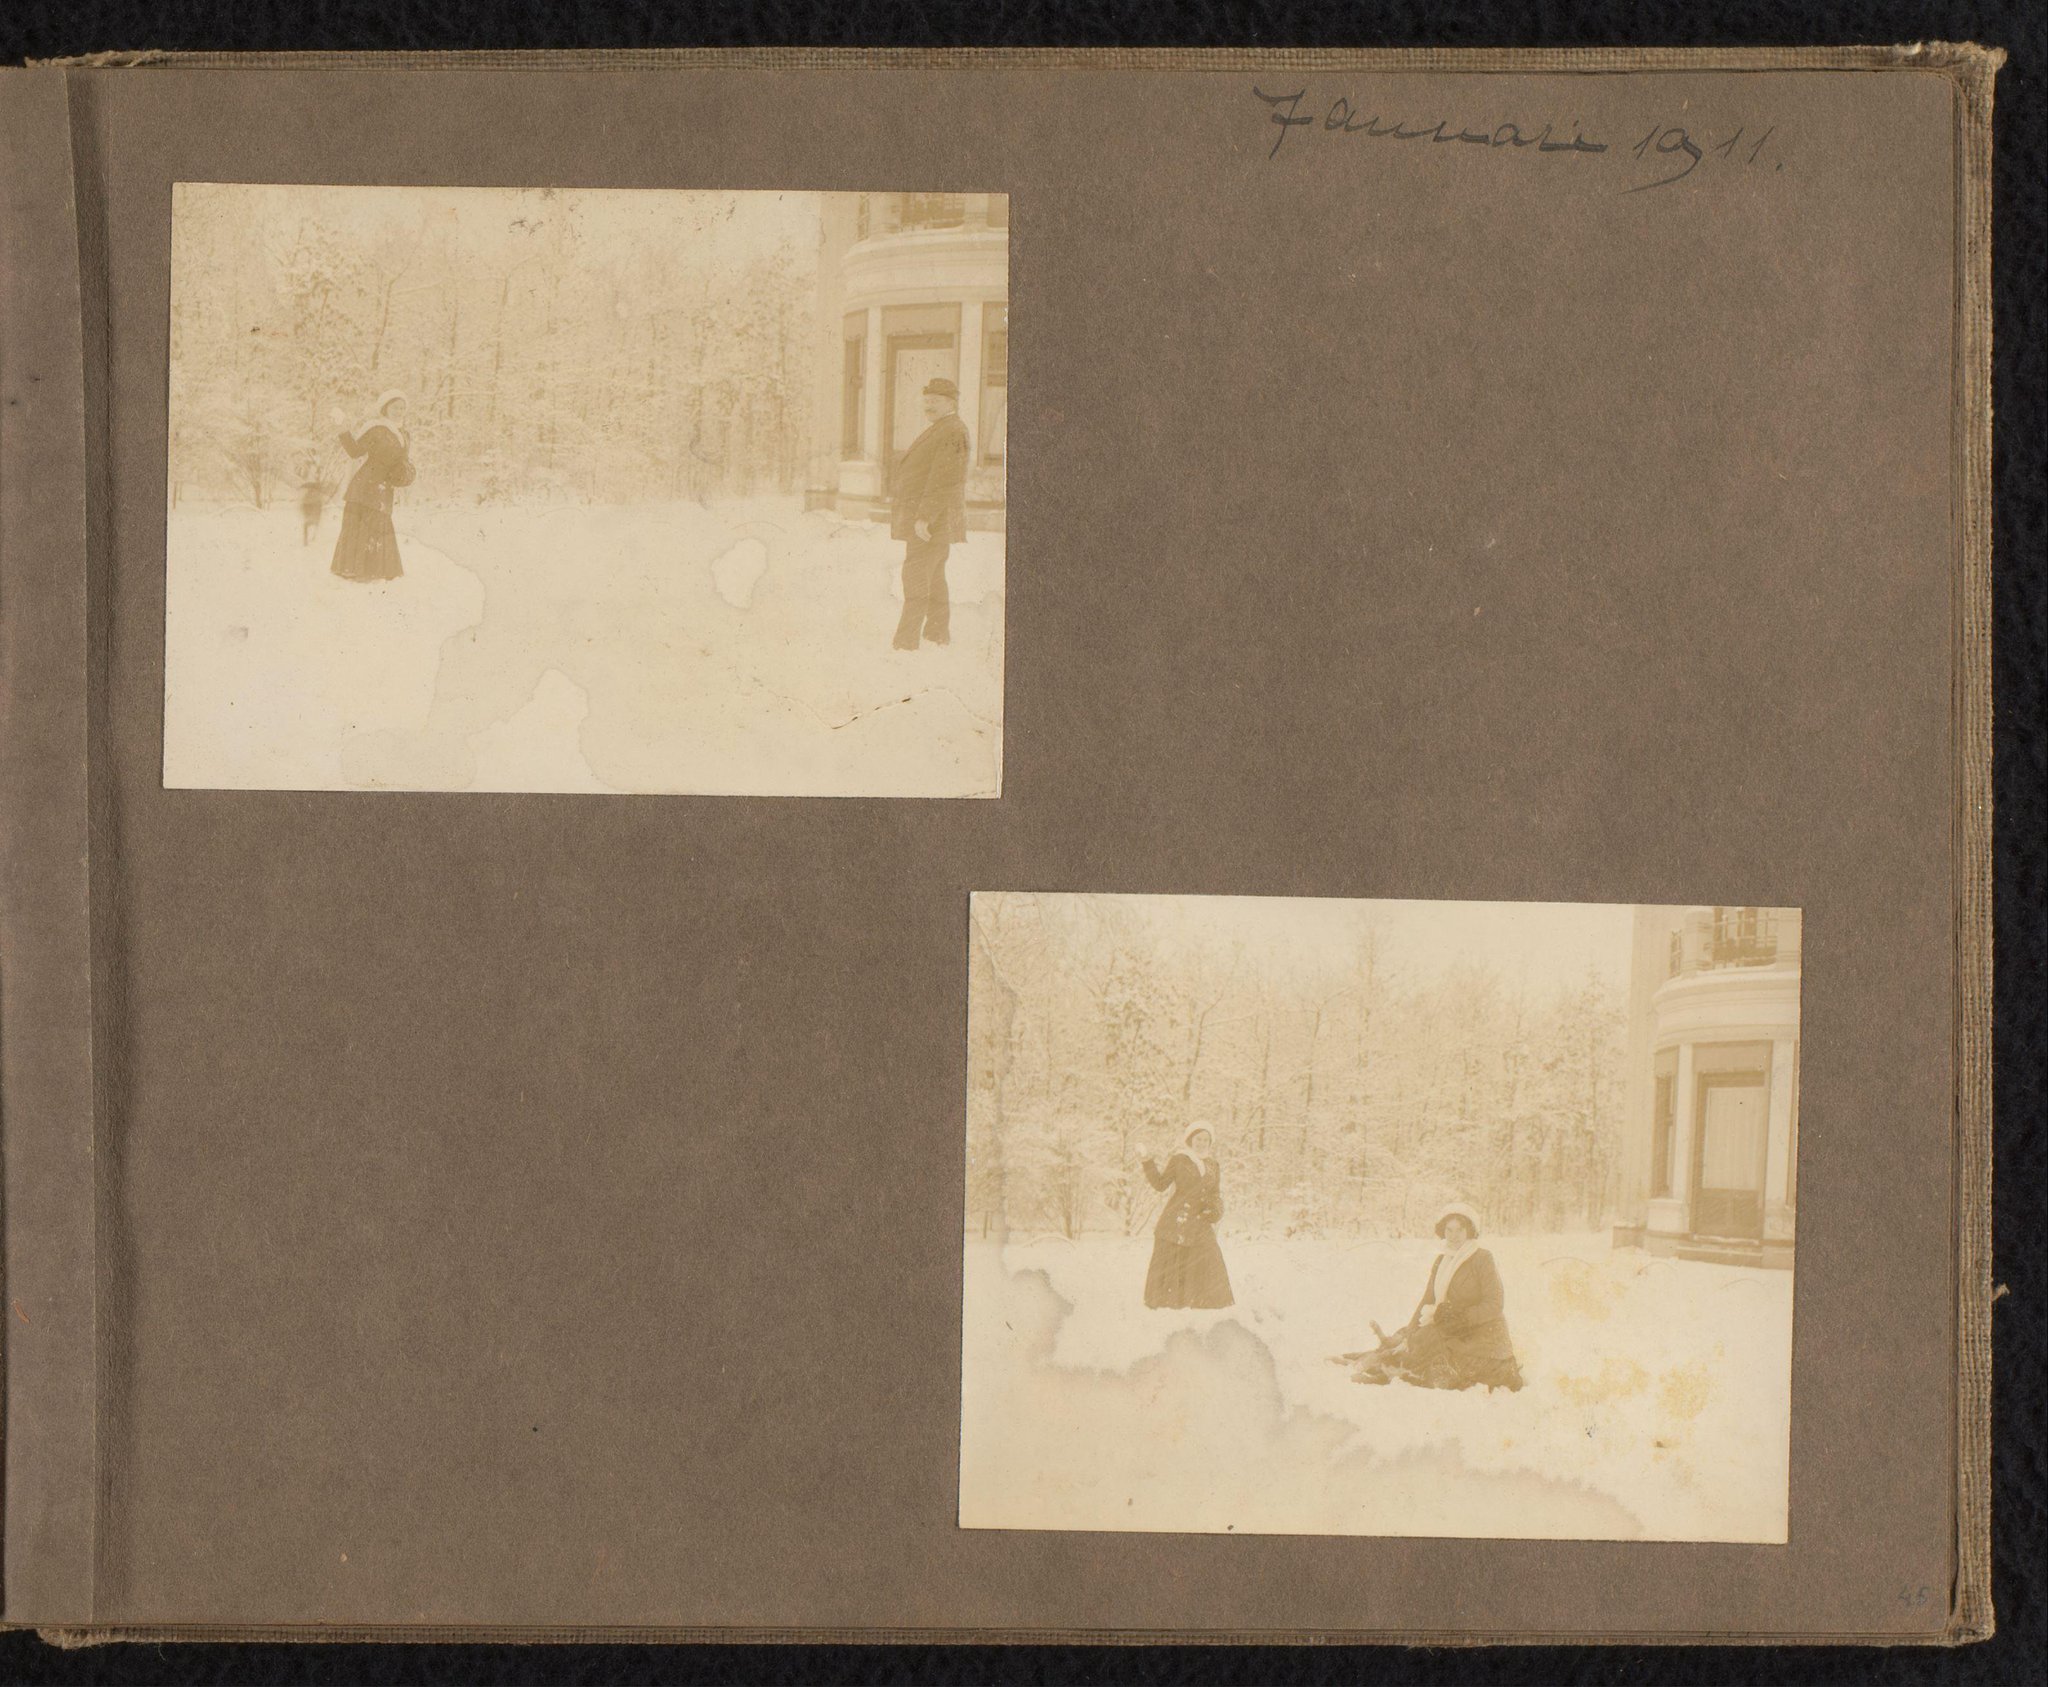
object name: album leaf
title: Januari 1911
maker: carolina frederika onnen (lien/loen)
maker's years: 1896-1983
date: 1901-1911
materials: paper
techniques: collodion silver print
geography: hilversum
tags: historical persons, snow, throwing snowballs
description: Deze foto's maken deel uit van een album.